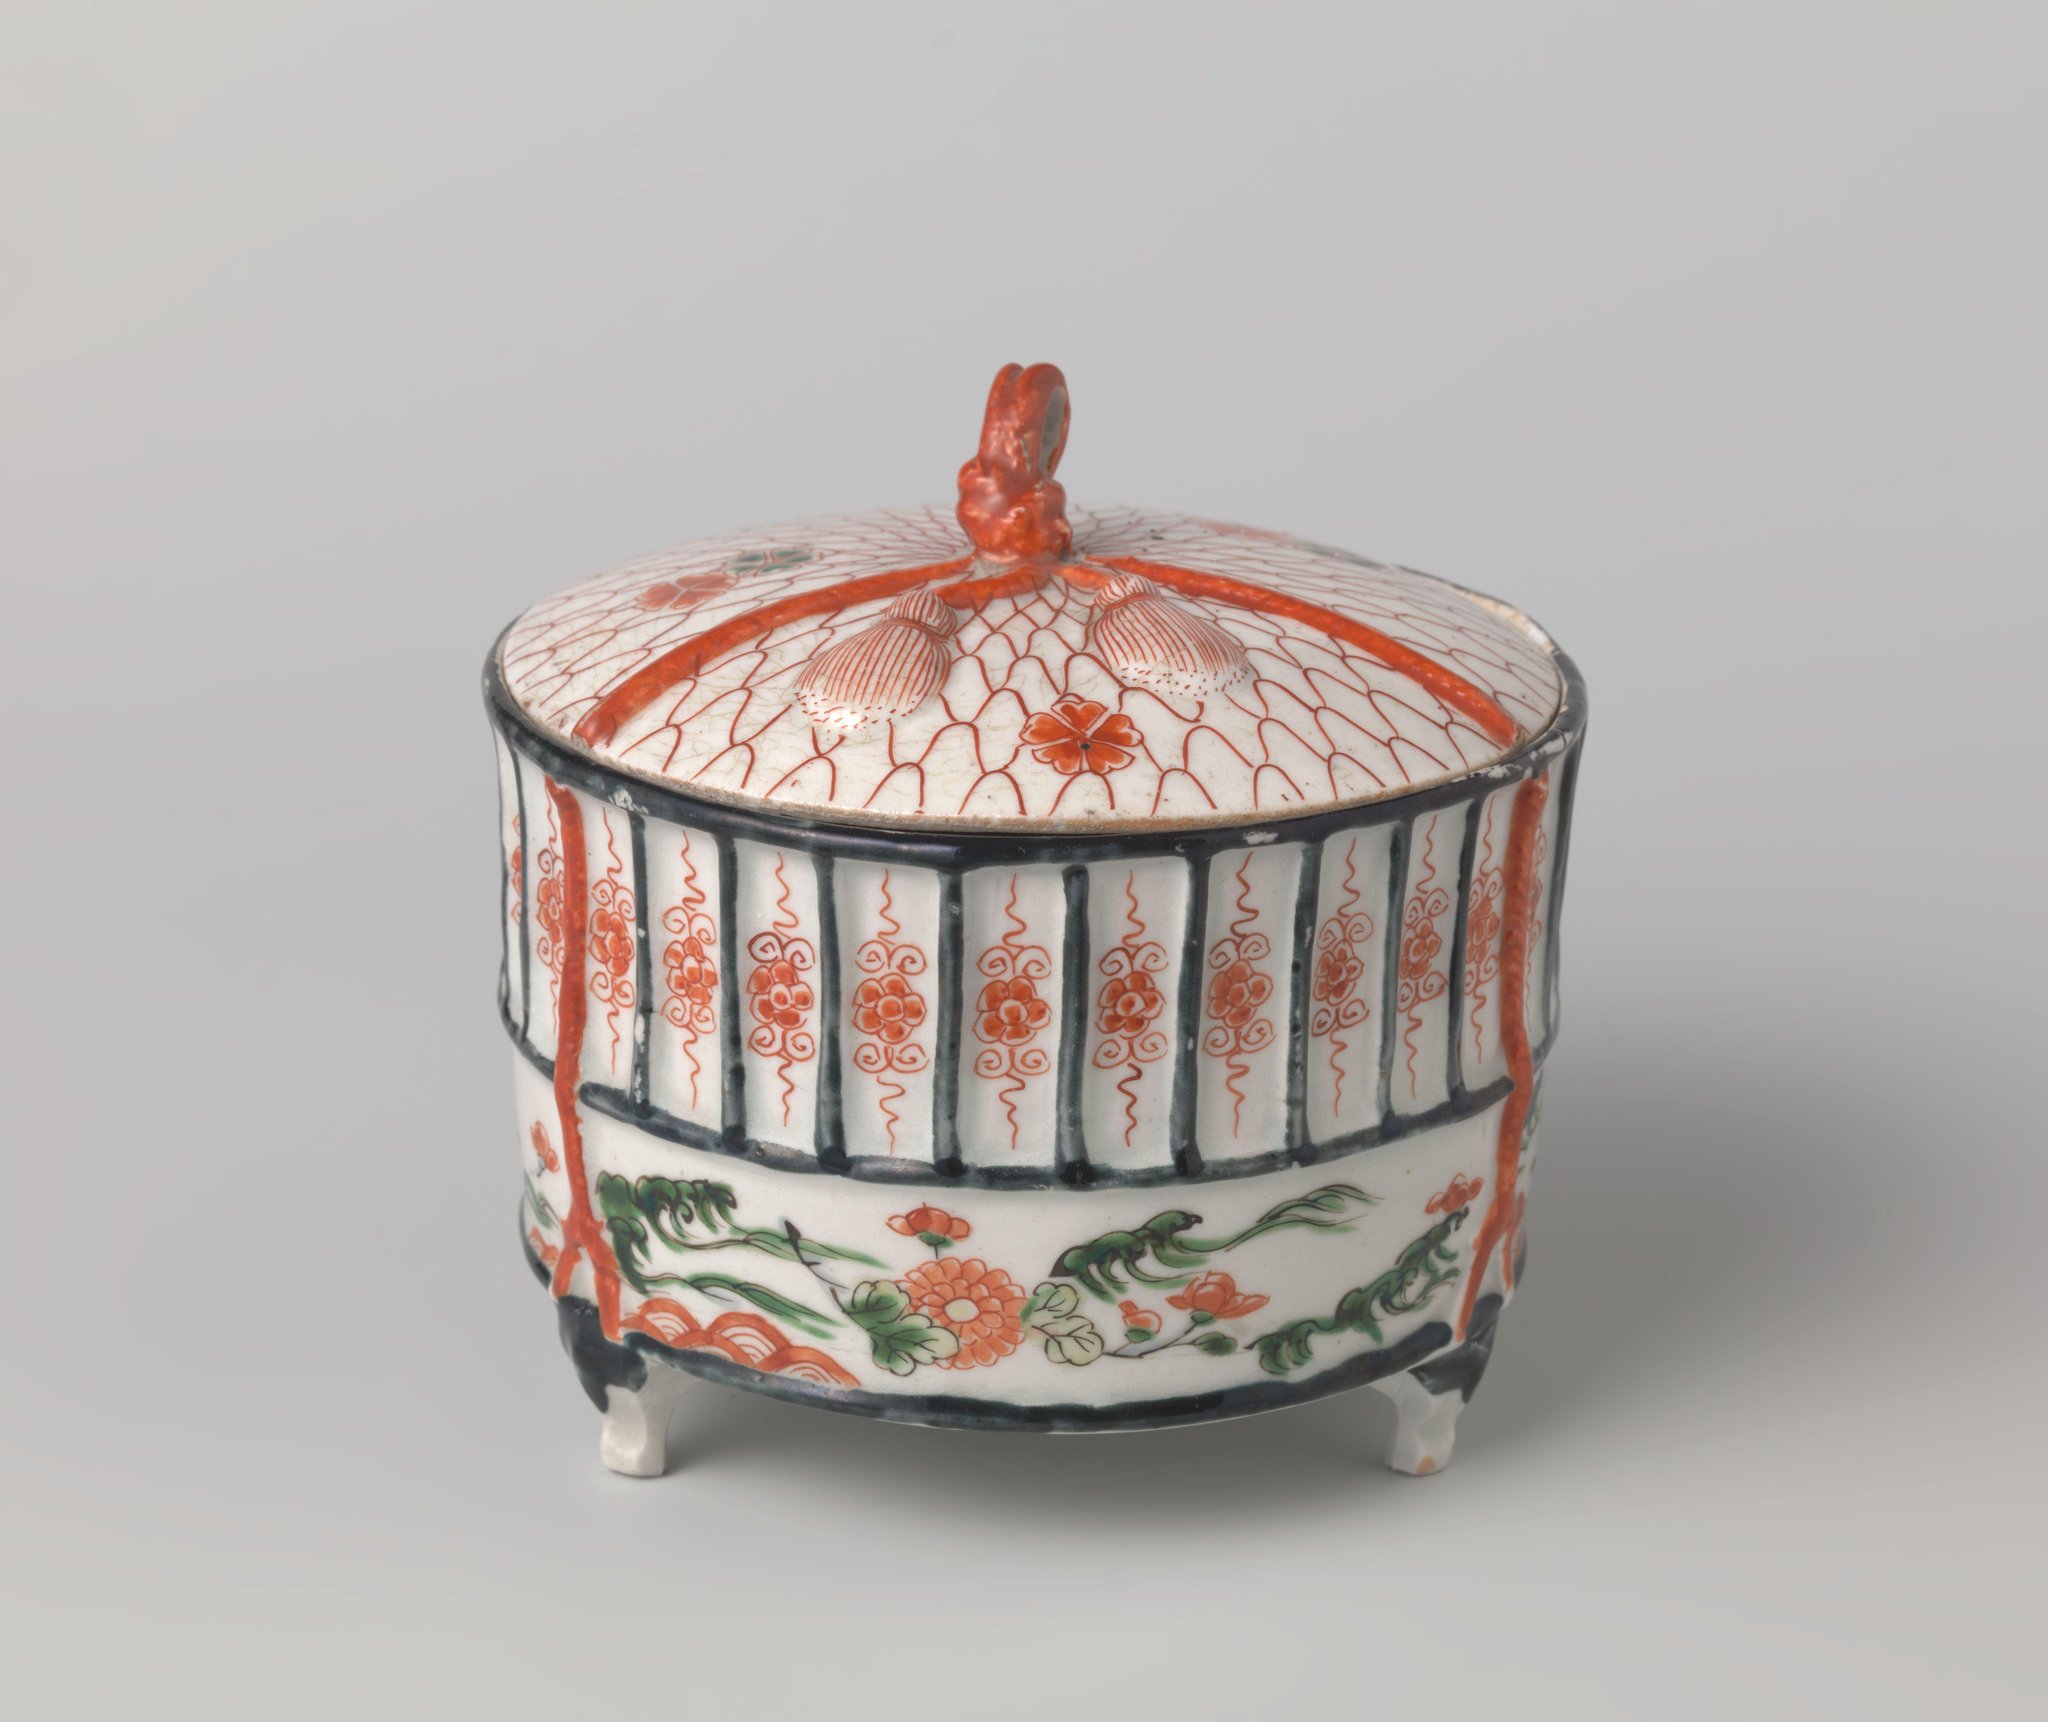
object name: box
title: Cilidrical covered box in the shape of a cricket's cage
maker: Anonymous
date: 1675-1699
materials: cobalt, glaze, paint, porcelain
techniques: firing, forming, turning, vitrification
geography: japan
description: Cilindrische doos van porselein op drie poten en in de vorm van een krekelkooi bijeengehouden door drie gemodelleerde koorden, eindigend in een opstaande knoop als dekselknop. Beschilderd in onderglazuur blauw en op het glazuur rood, groen, geel en zwart. De onderste helft van de doos met golven, vogels en bloemtakken; de bovenste helft is gemodelleerd in traliewerk met in elk vak een bloemrank. Imari.